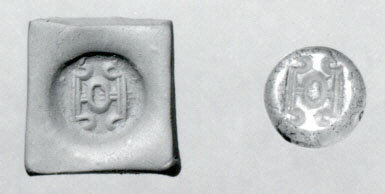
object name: stamp seal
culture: sasanian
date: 201-700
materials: quartz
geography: iran or mesopotamia